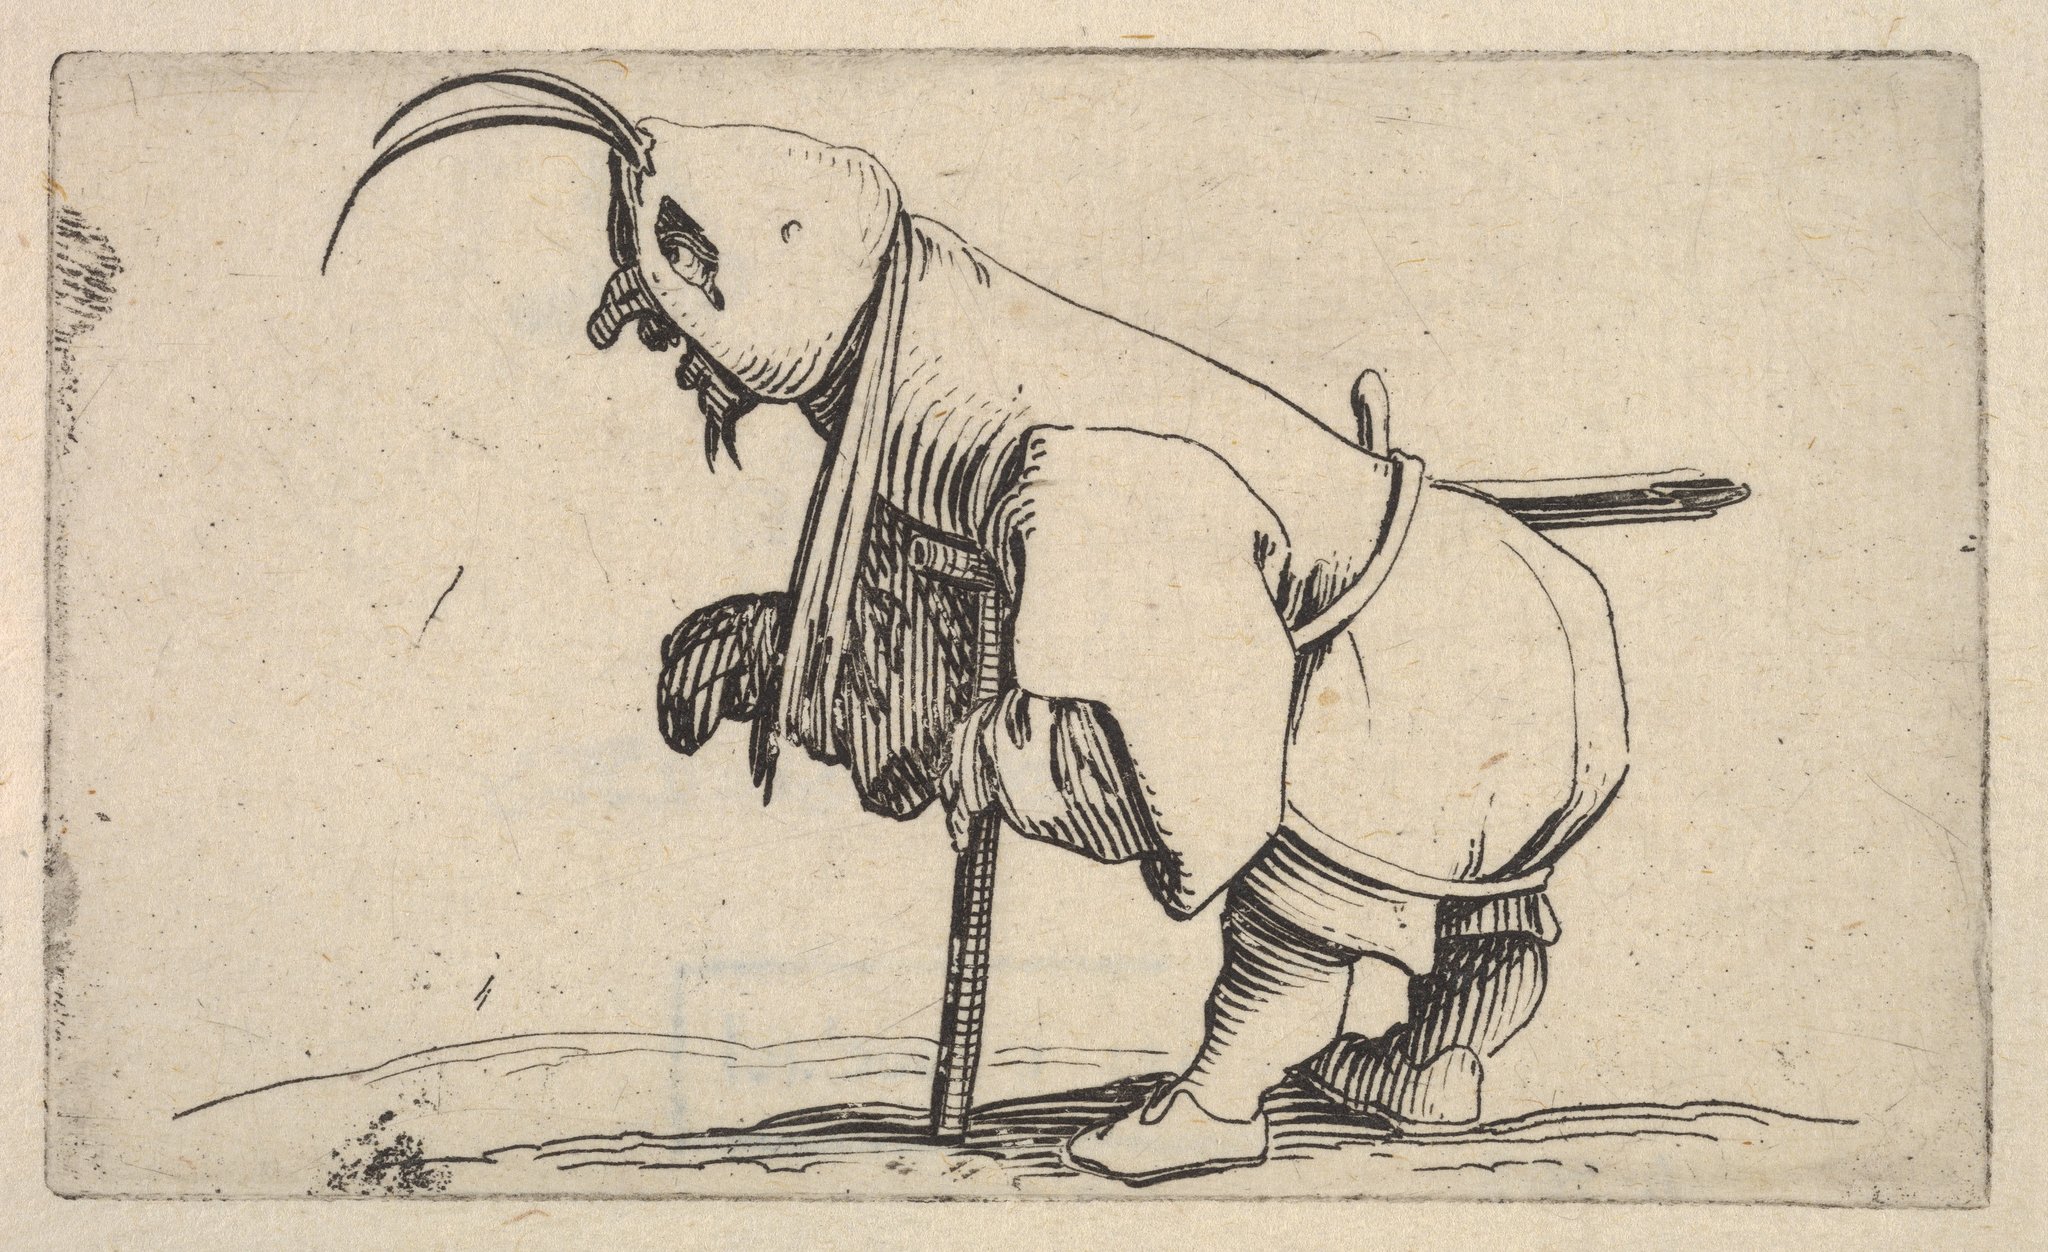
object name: print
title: Hooded small figure hunched over a crutch, in profile view with left leg positioned forward and sword affixed to right hip, from "Varie Figure Gobbi"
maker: jacques callot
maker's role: artist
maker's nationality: french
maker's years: 1592-1635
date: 1621-1625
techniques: etching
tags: human figures,swords